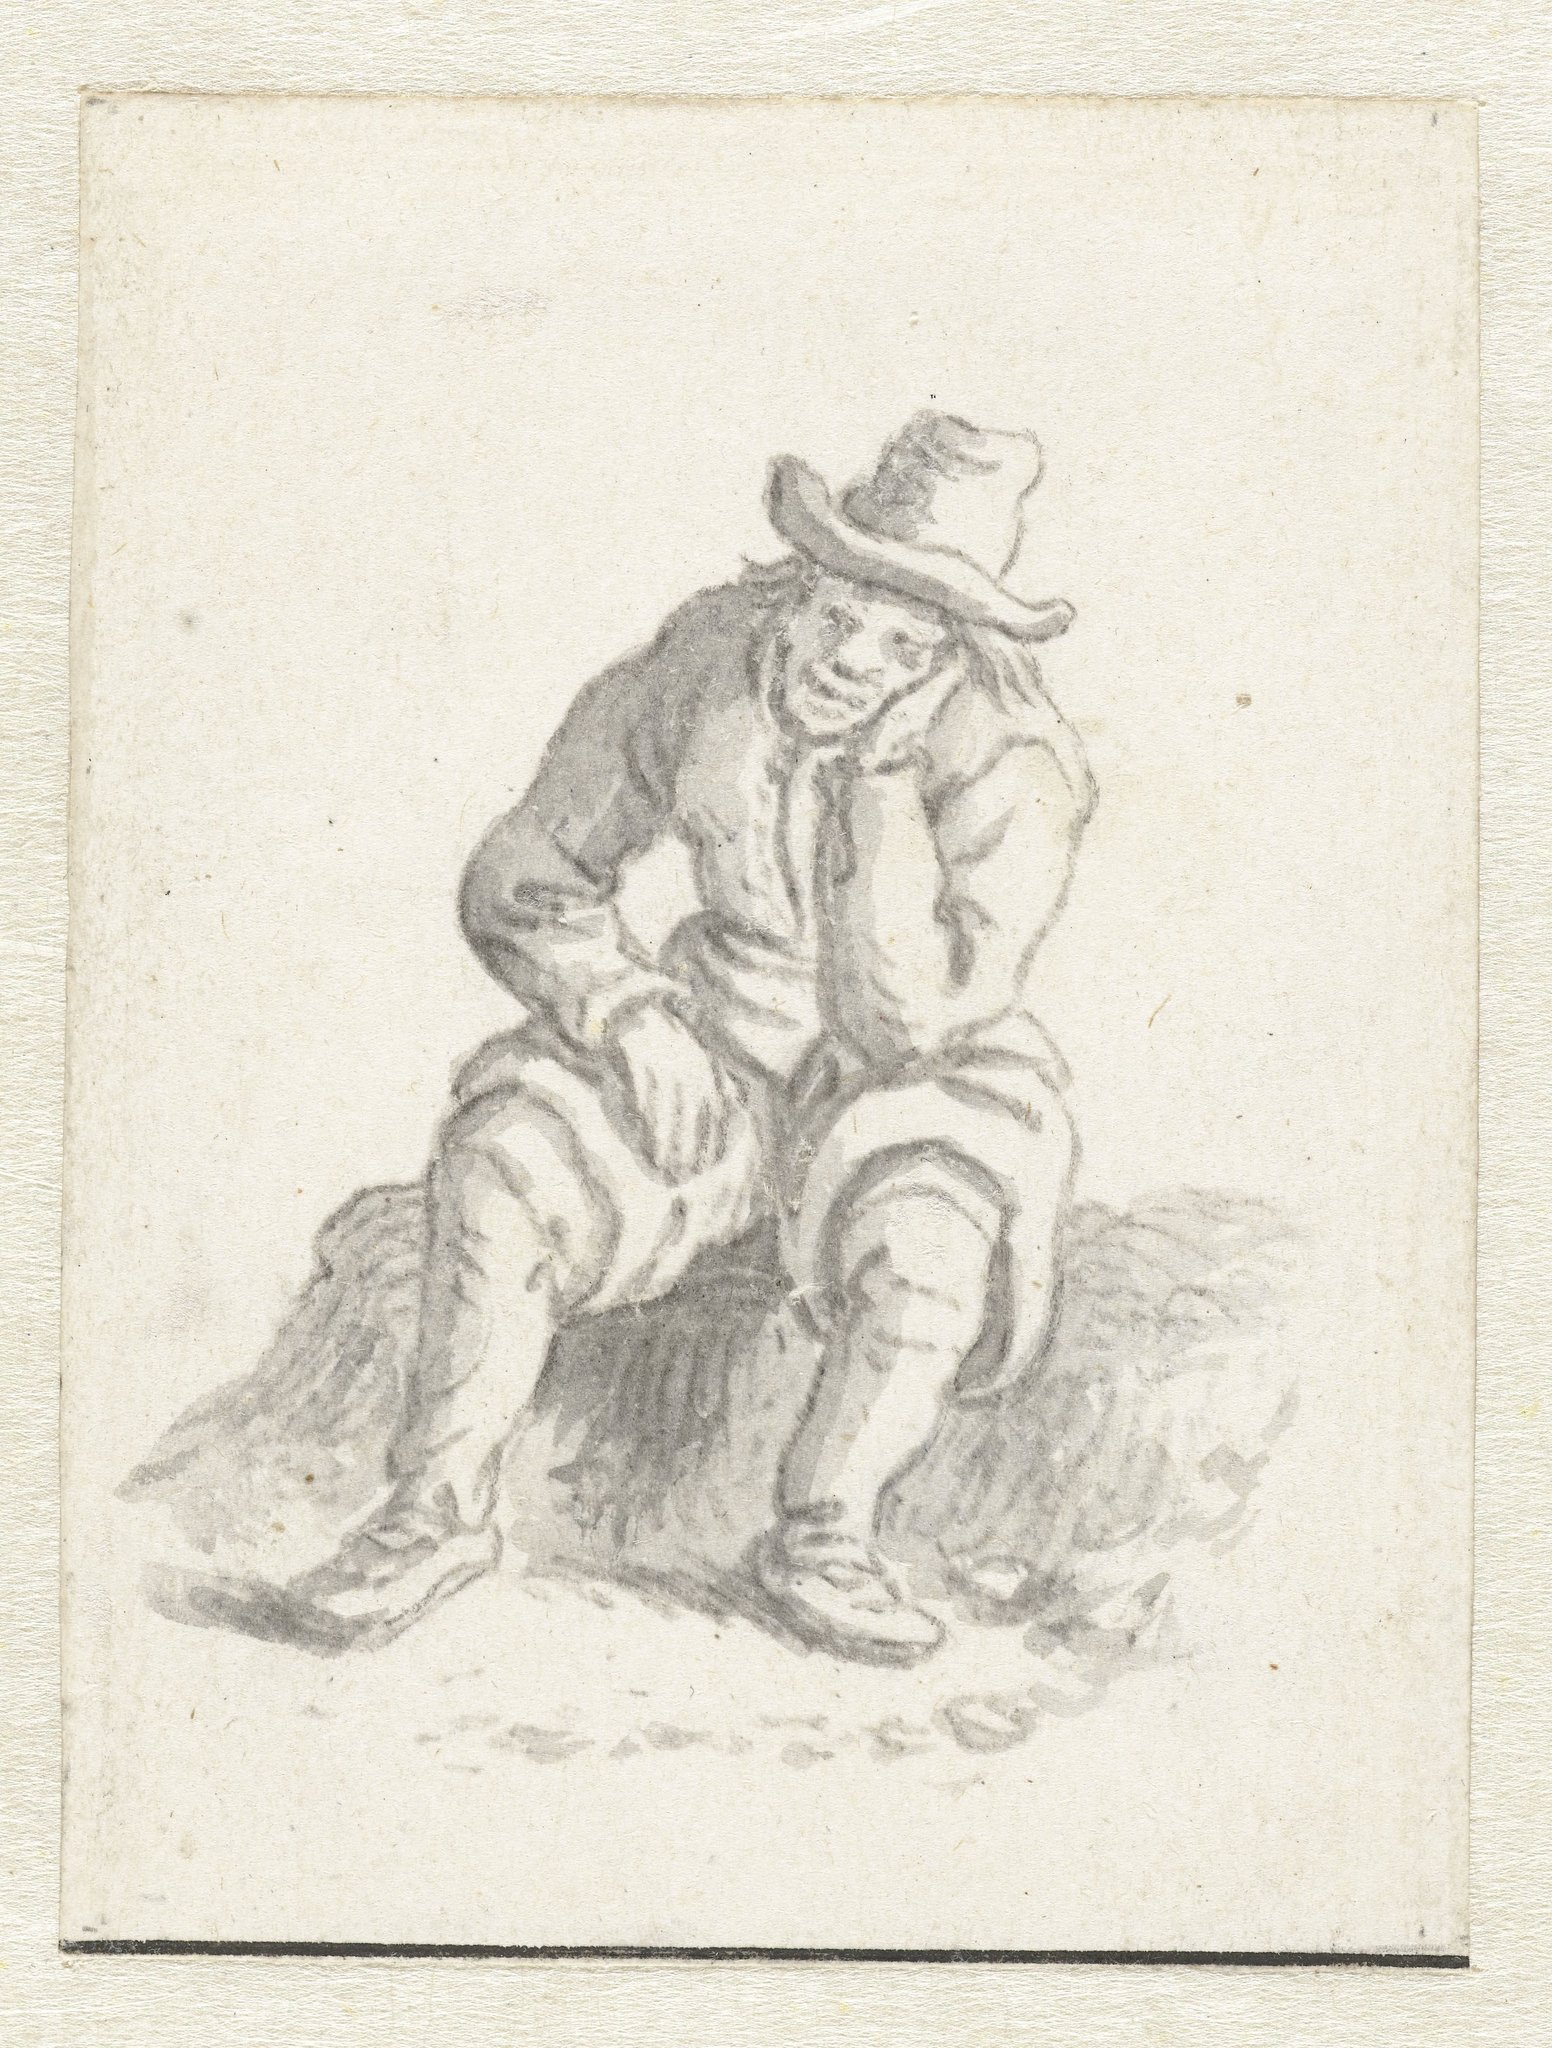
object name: drawing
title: Zittende man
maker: herman saftleven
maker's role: draughtsman, painter, print maker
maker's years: 1609-1685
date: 1619-1685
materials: chalk, paper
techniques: brush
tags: sitting figure